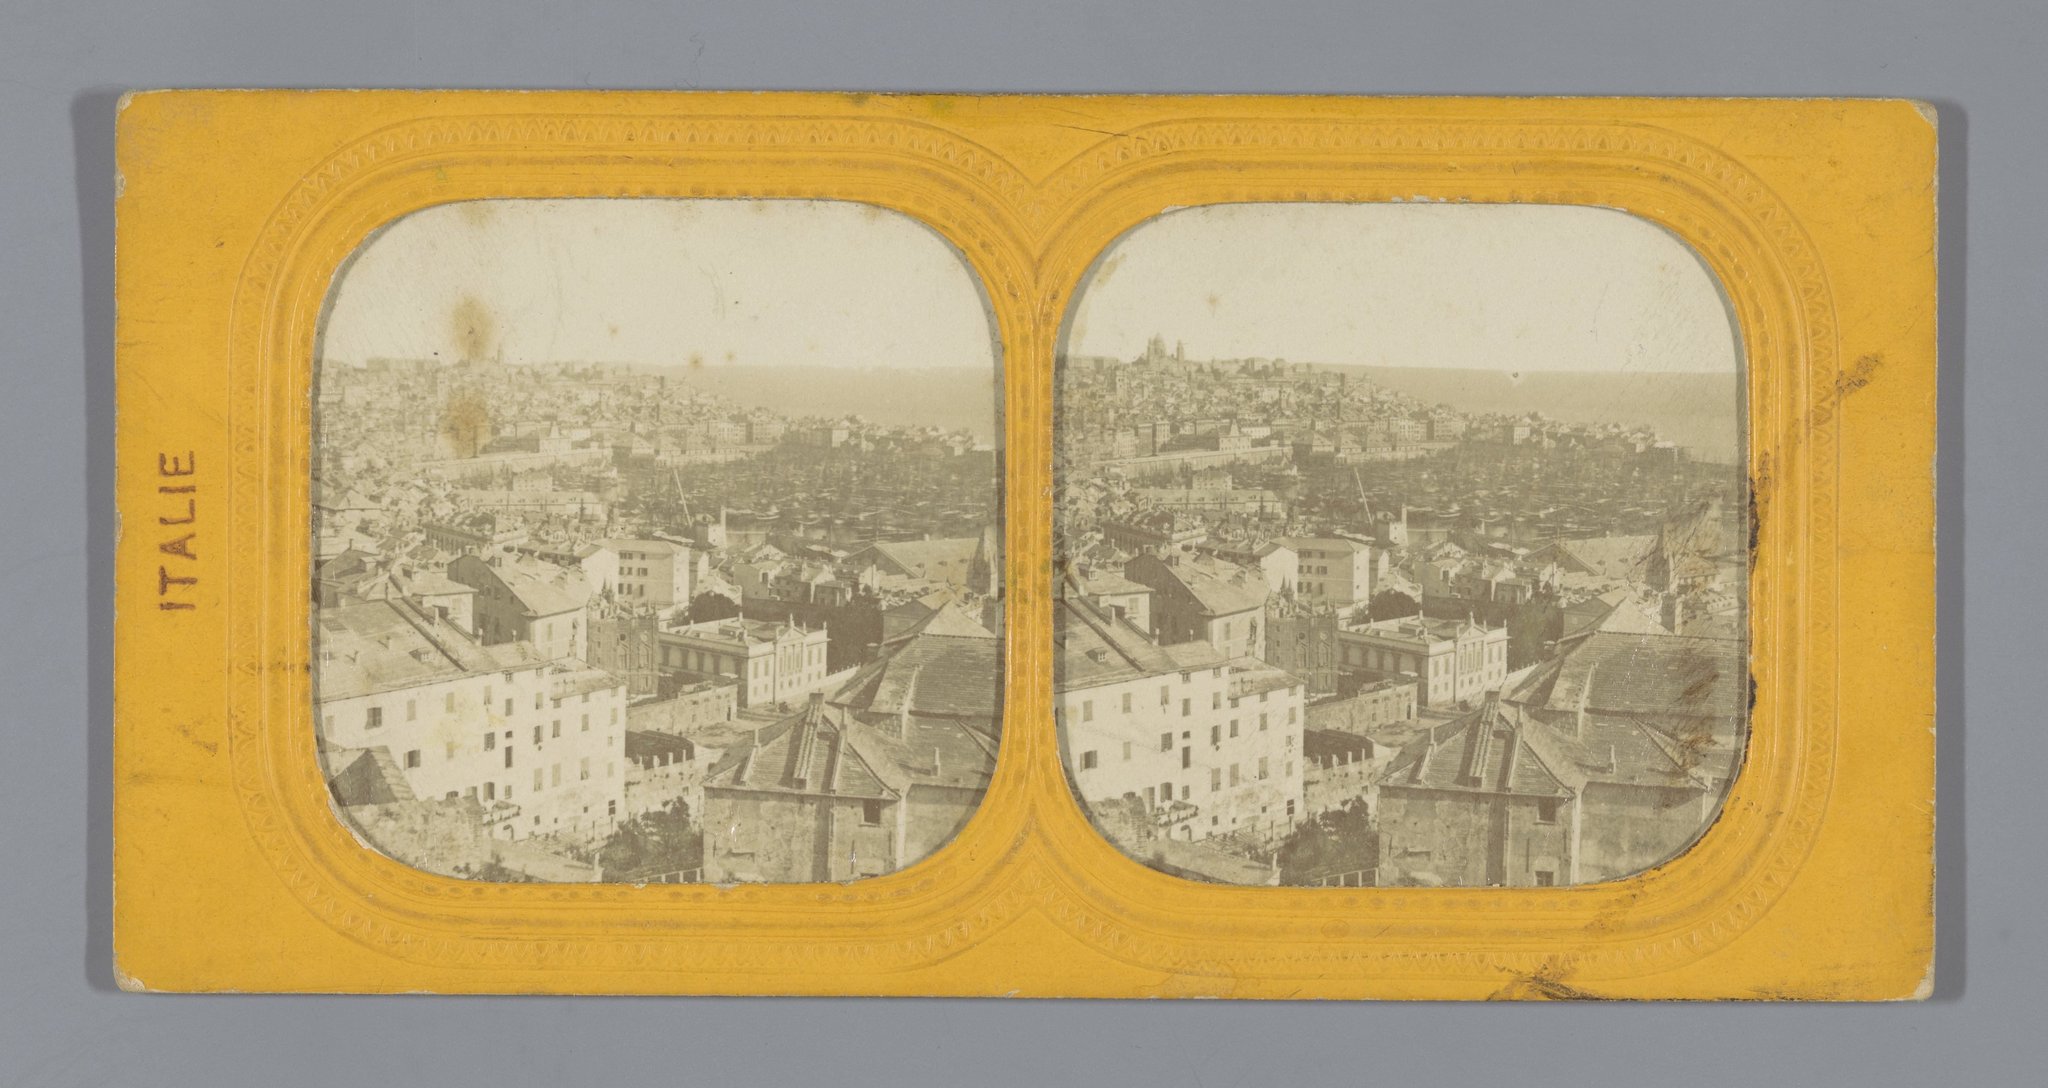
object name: tissue stereograph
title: Italie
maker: Anonymous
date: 1855-1875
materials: cardboard, paper, photographic support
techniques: albumen print, hand coloring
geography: genoa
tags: city-view in general; 'veduta'